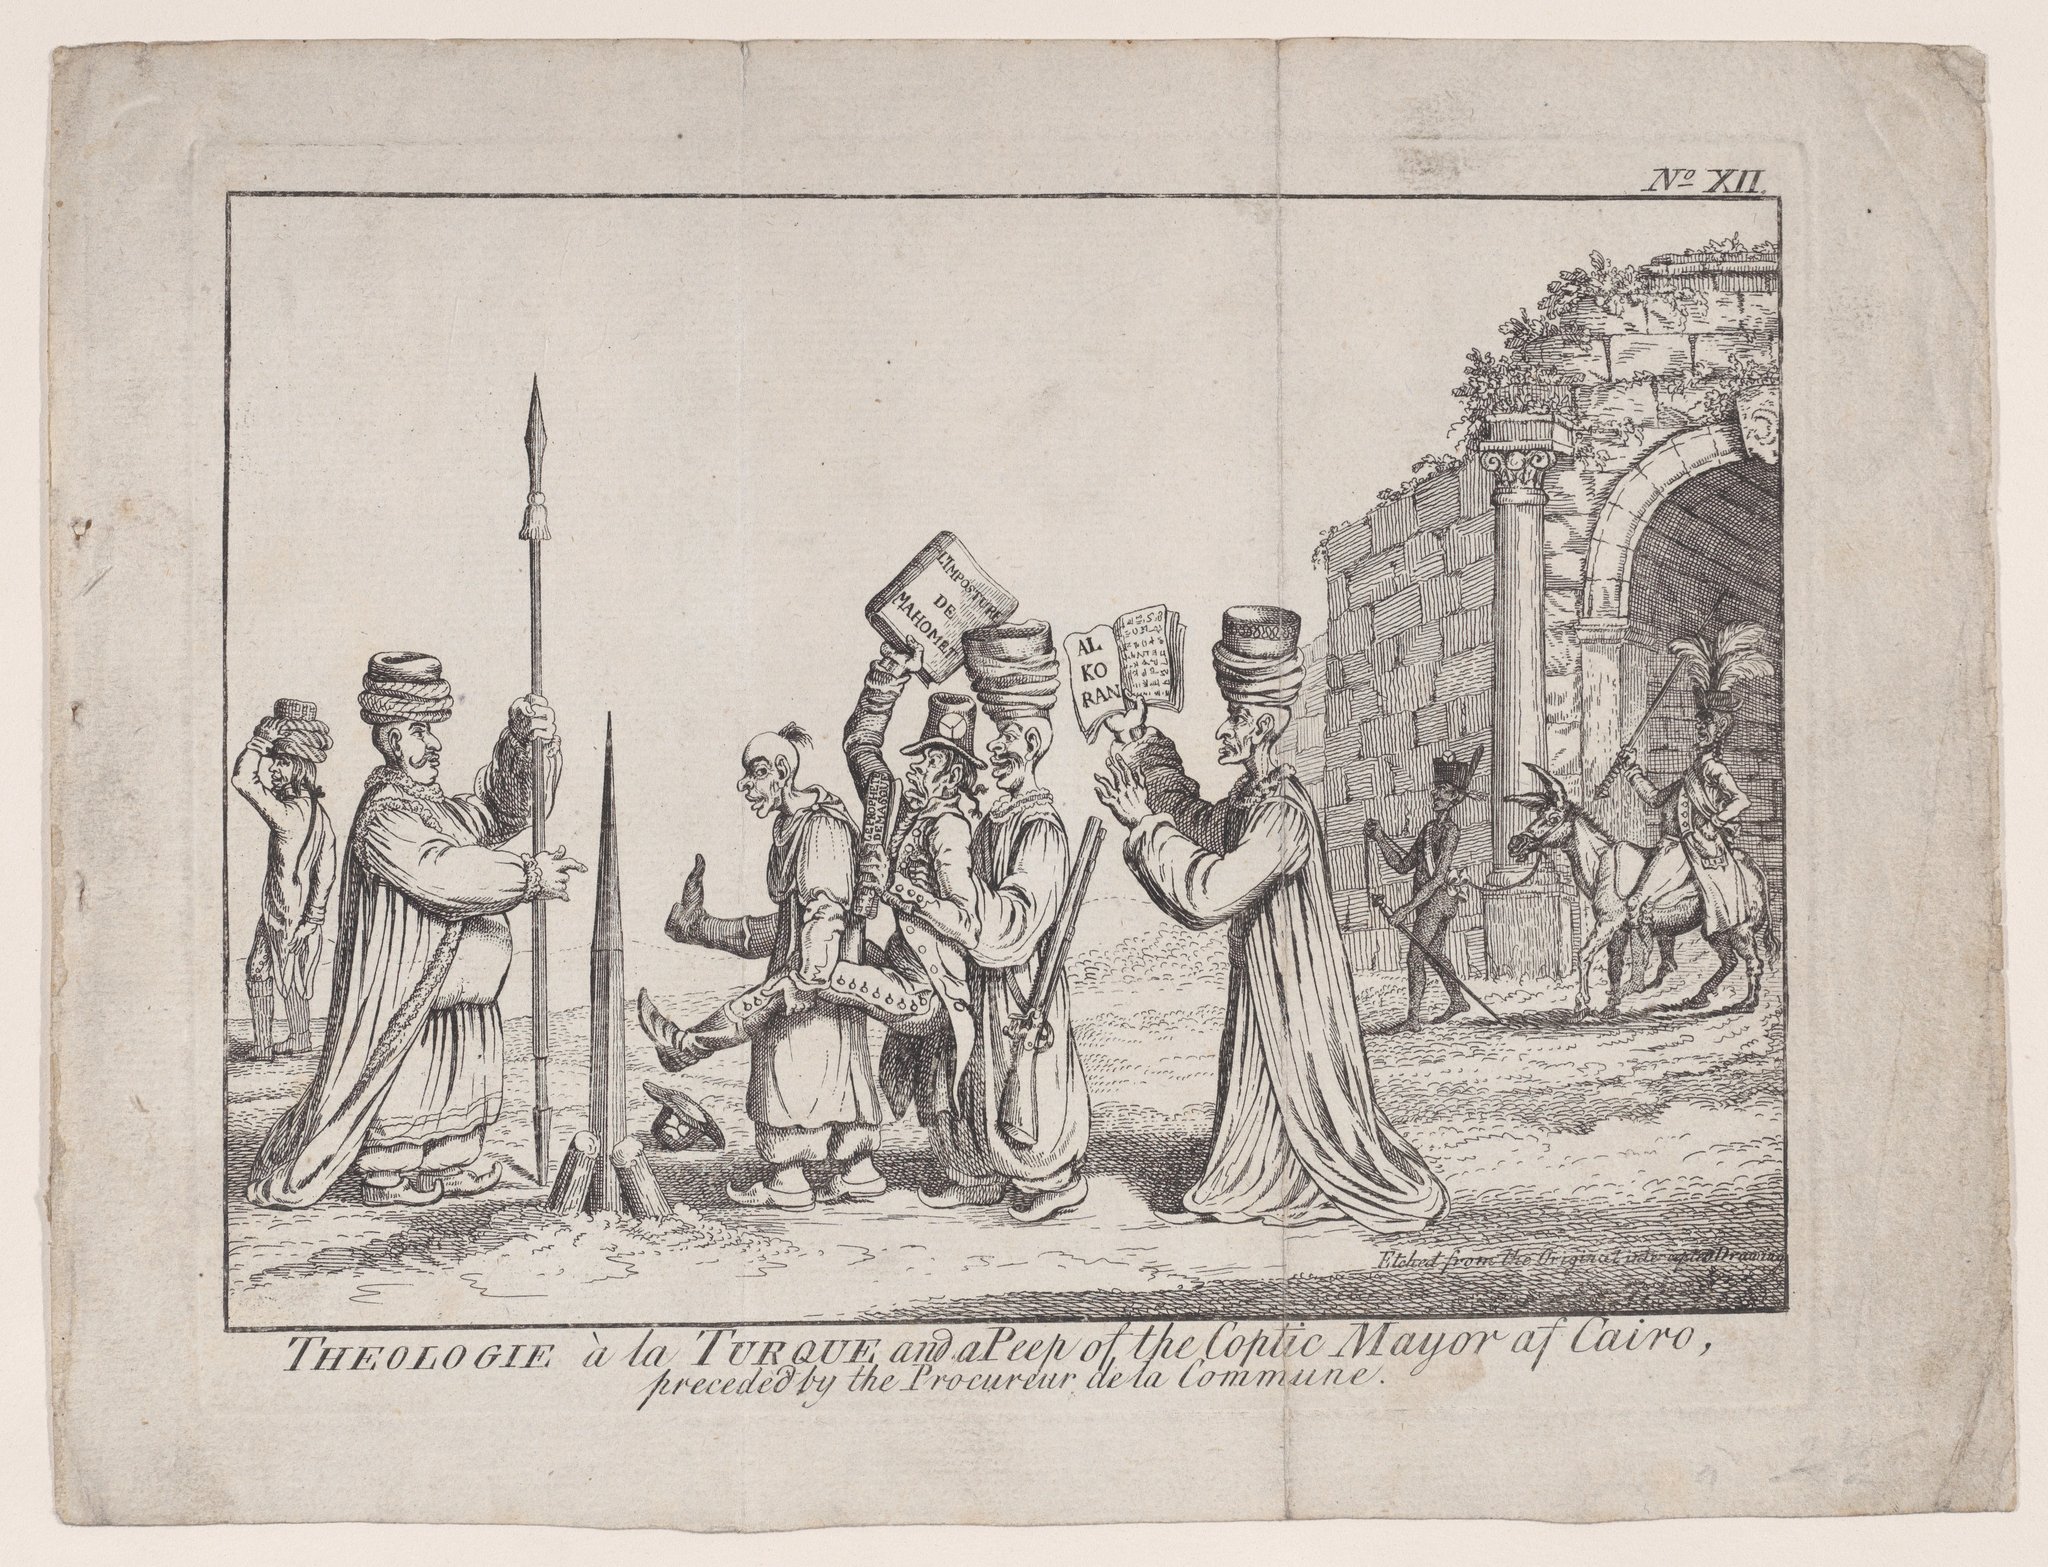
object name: print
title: Theologie à la Turque and a Peep of the Coptic Mayor at Cairo, preceded by the Procureur de la Commune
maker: james gillray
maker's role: artist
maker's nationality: british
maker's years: 1756-1815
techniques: etching